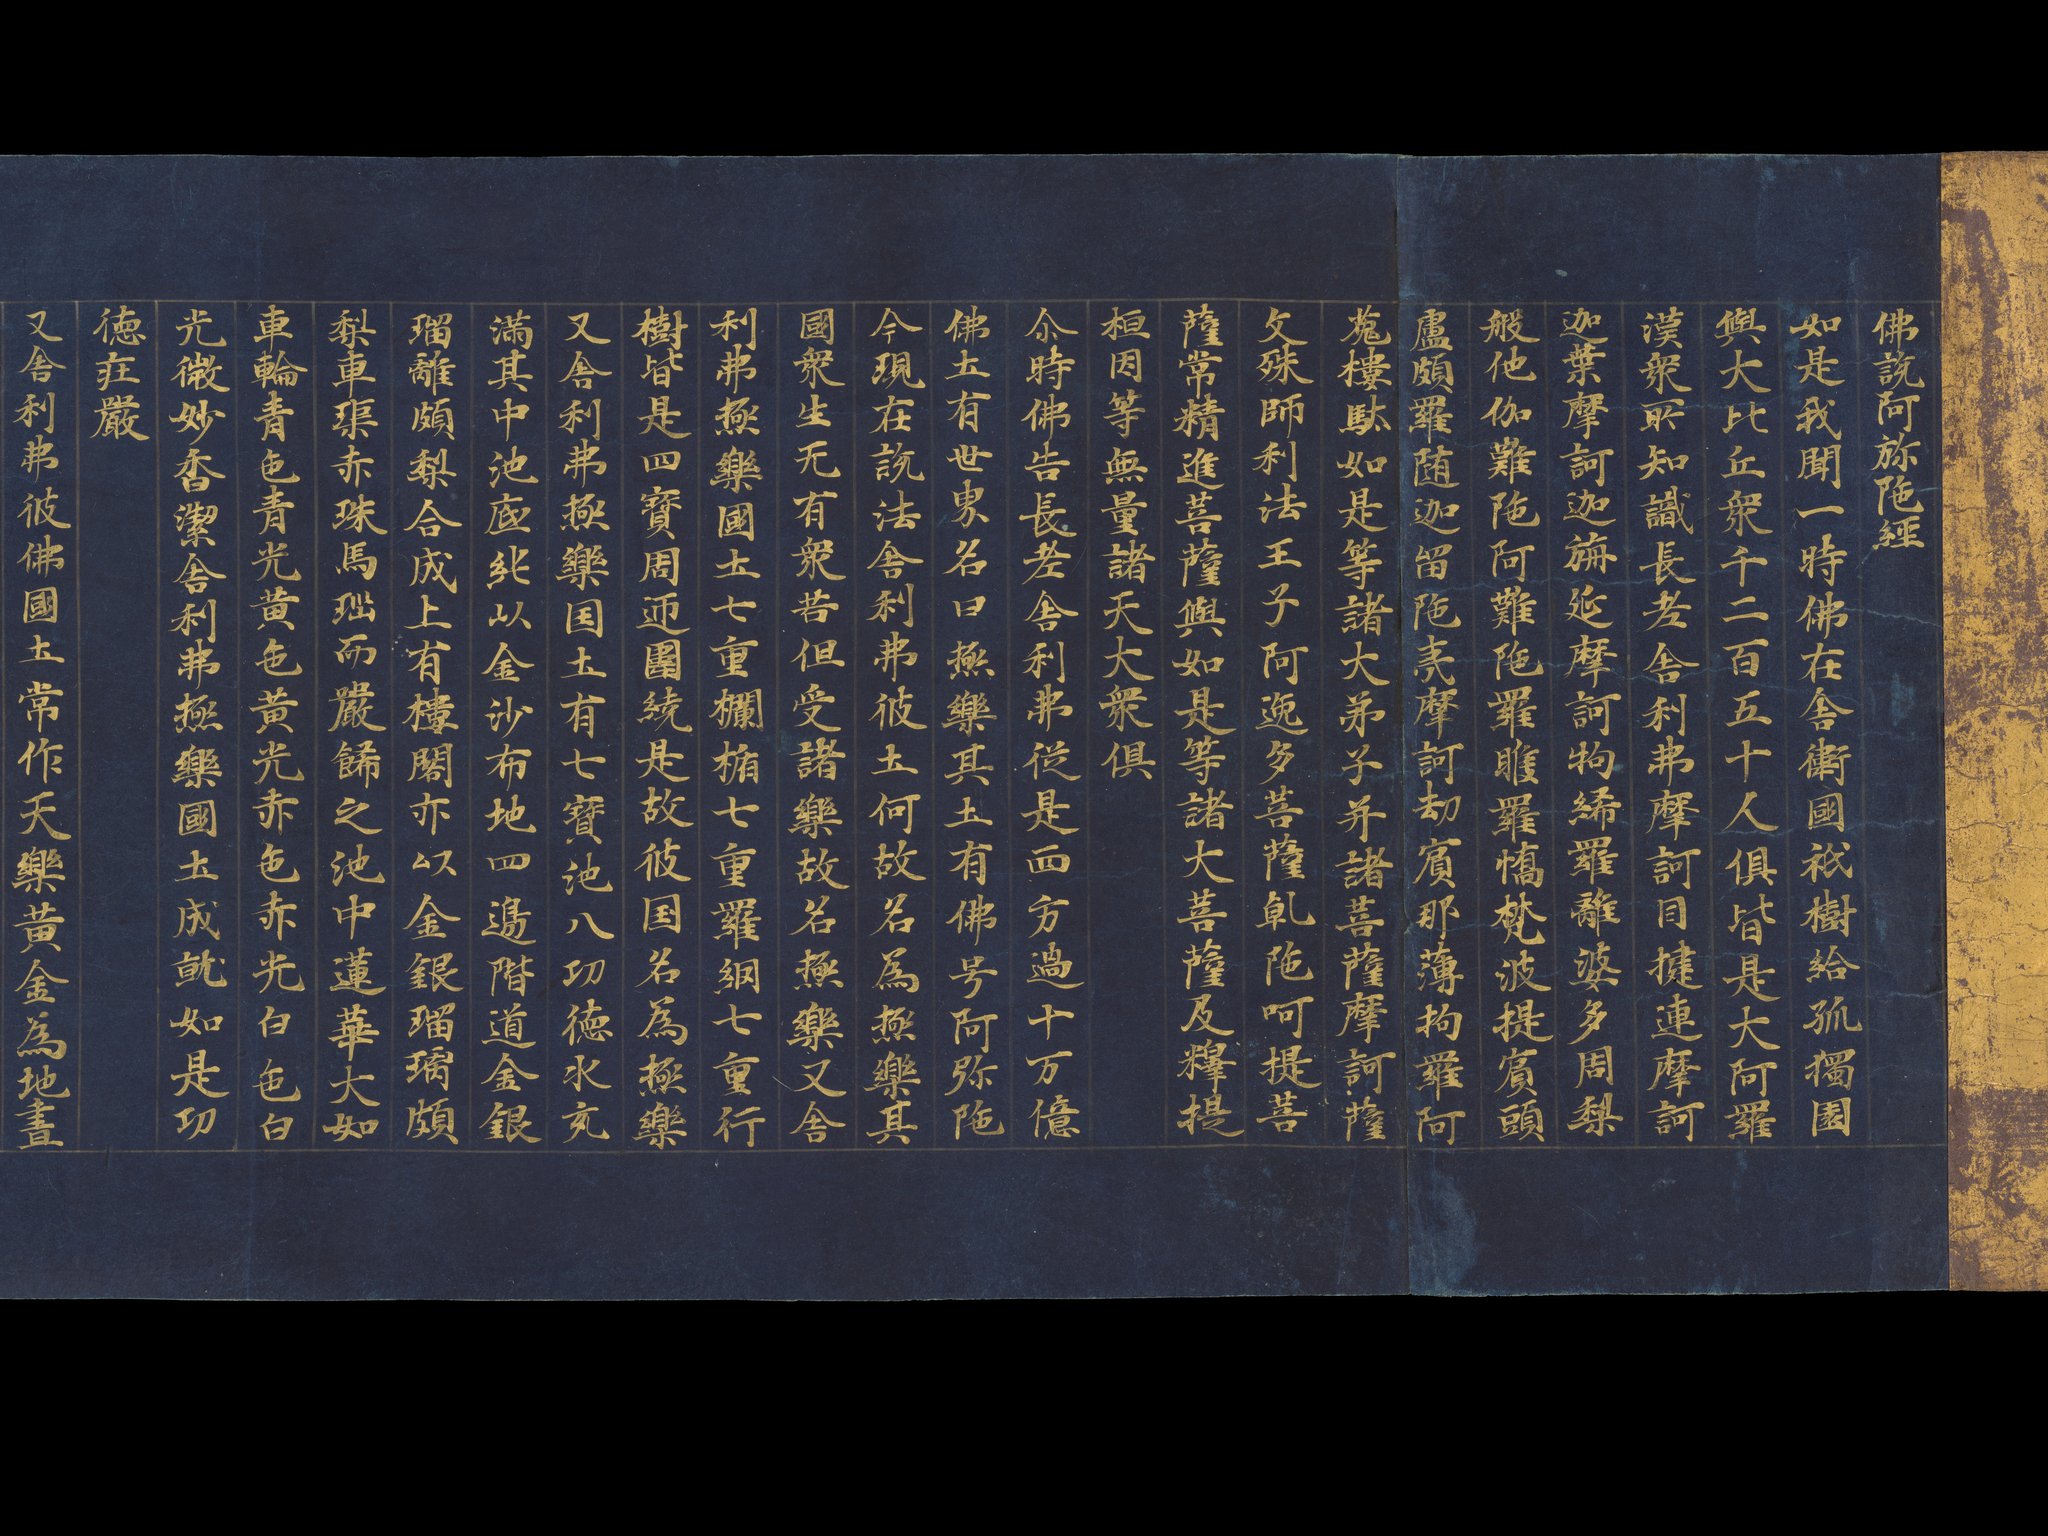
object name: handscroll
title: Section of The Amitabha Sutra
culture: japanese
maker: unidentified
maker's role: artist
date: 1234-1266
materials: gold, paper, silver